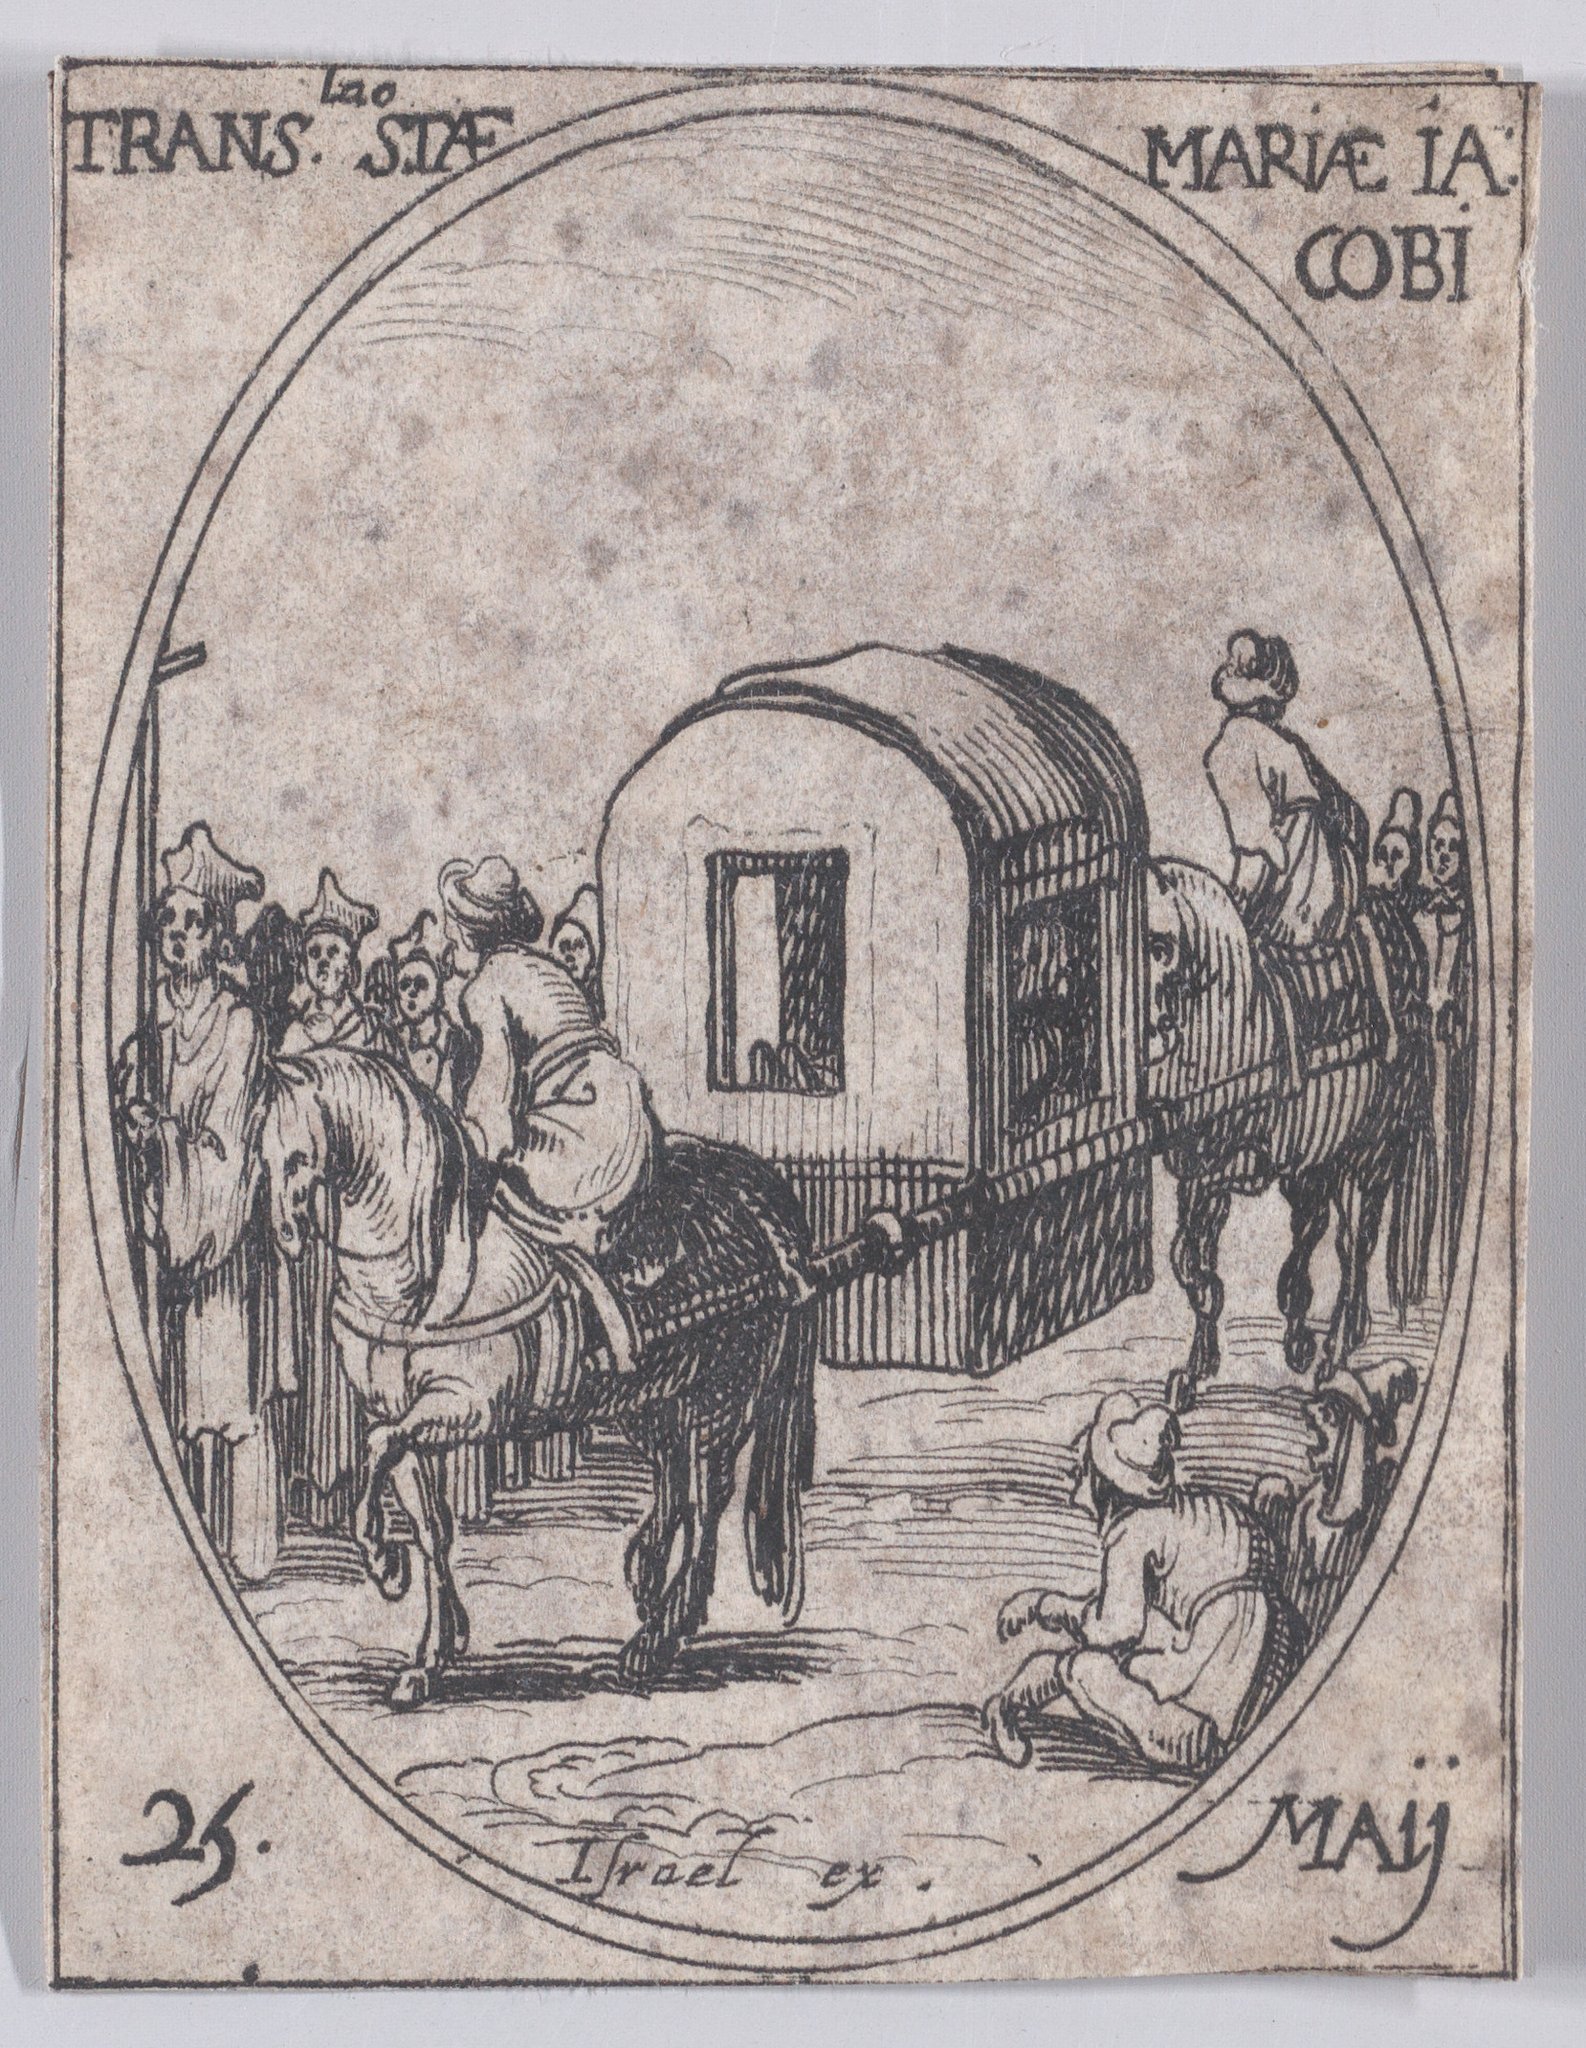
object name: print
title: La Translation de Ste. Marie, Mère de S. Jacques (The Translation of St. Mary, Mother of St. James), May 25th, from "Les Images De Tous Les Saincts et Saintes de L'Année" (Images of All of the Saints and Religious Events of the Year)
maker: jacques callot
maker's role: artist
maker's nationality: french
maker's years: 1592-1635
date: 1636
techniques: etching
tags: horses,saints